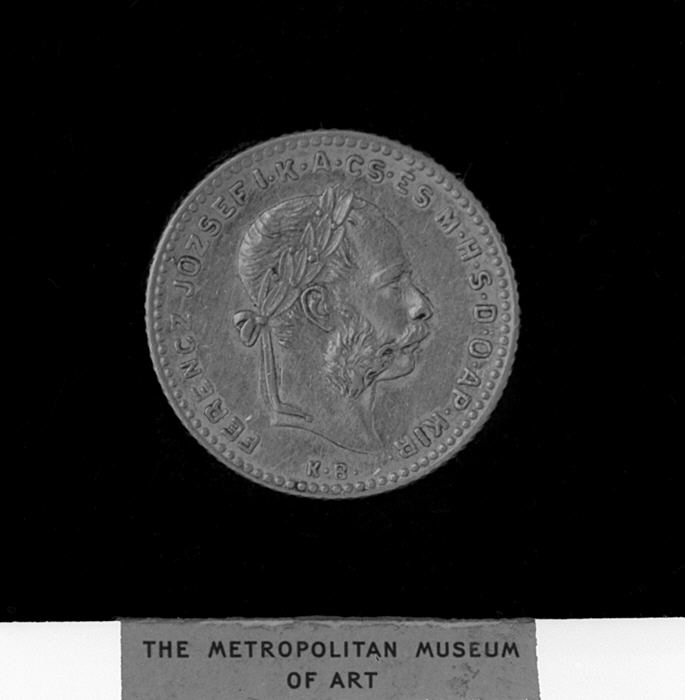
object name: coin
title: Emperor Francis Joseph as King of Hungary, 1891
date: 1891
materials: gold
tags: men,profiles